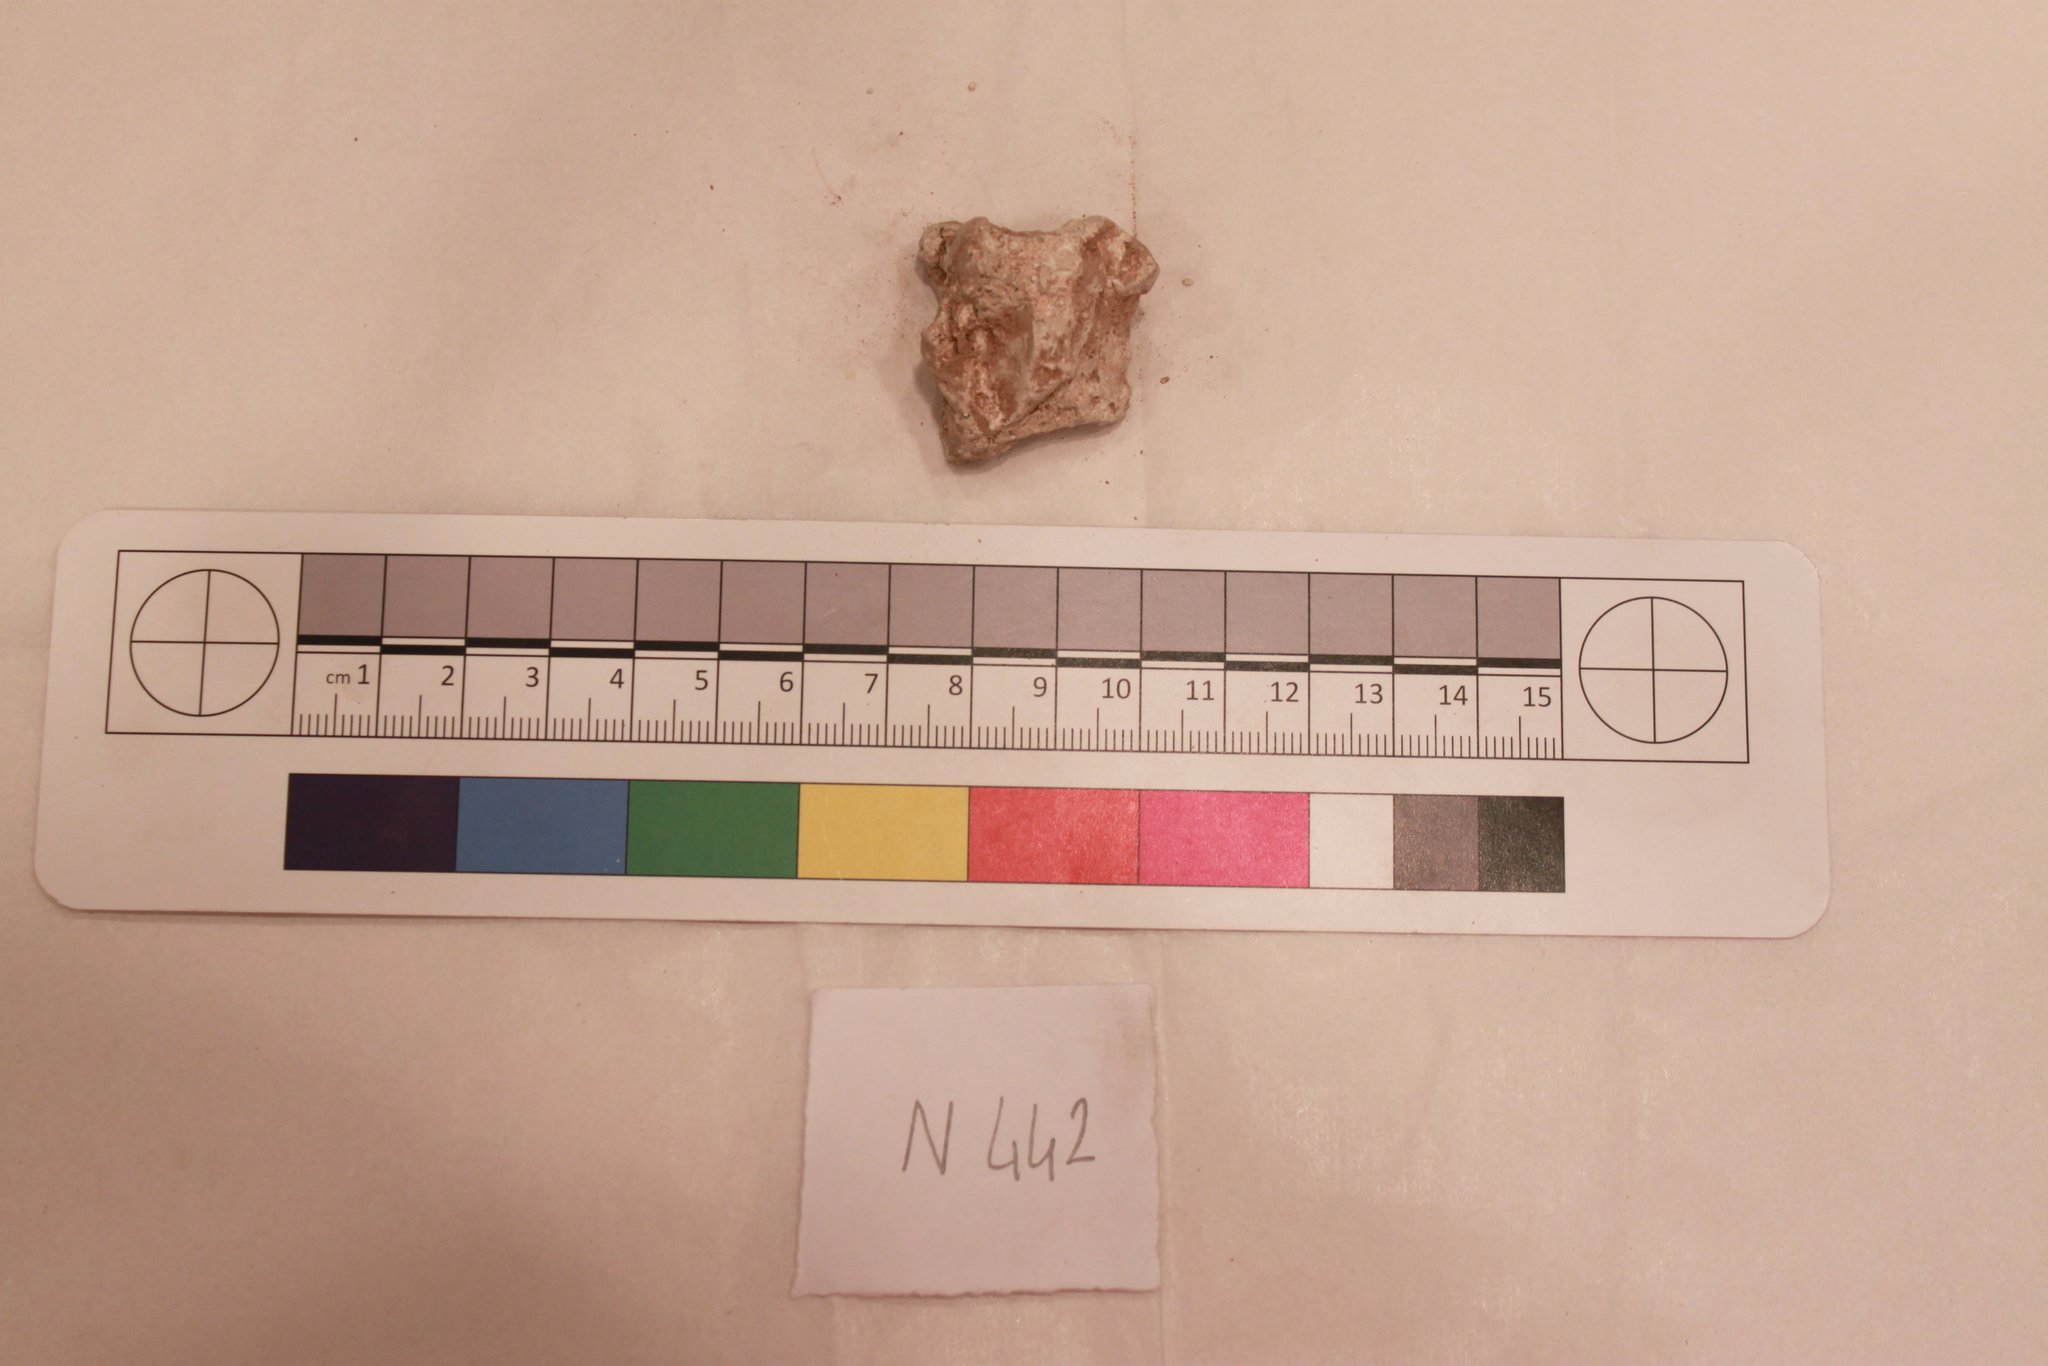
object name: fragment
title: Stucco Fragment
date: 701-1200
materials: plaster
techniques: carving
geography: iran